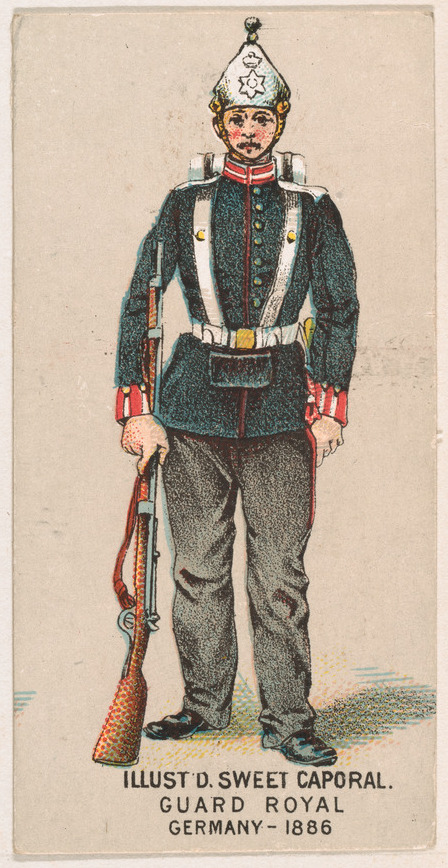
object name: print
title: Royal Guard, Germany, 1886, from the Military Series (N224) issued by Kinney Tobacco Company to promote Sweet Caporal Cigarettes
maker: kinney brothers tobacco company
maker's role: publisher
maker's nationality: american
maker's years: 1869-2011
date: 1888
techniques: color lithograph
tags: military,firearms,men